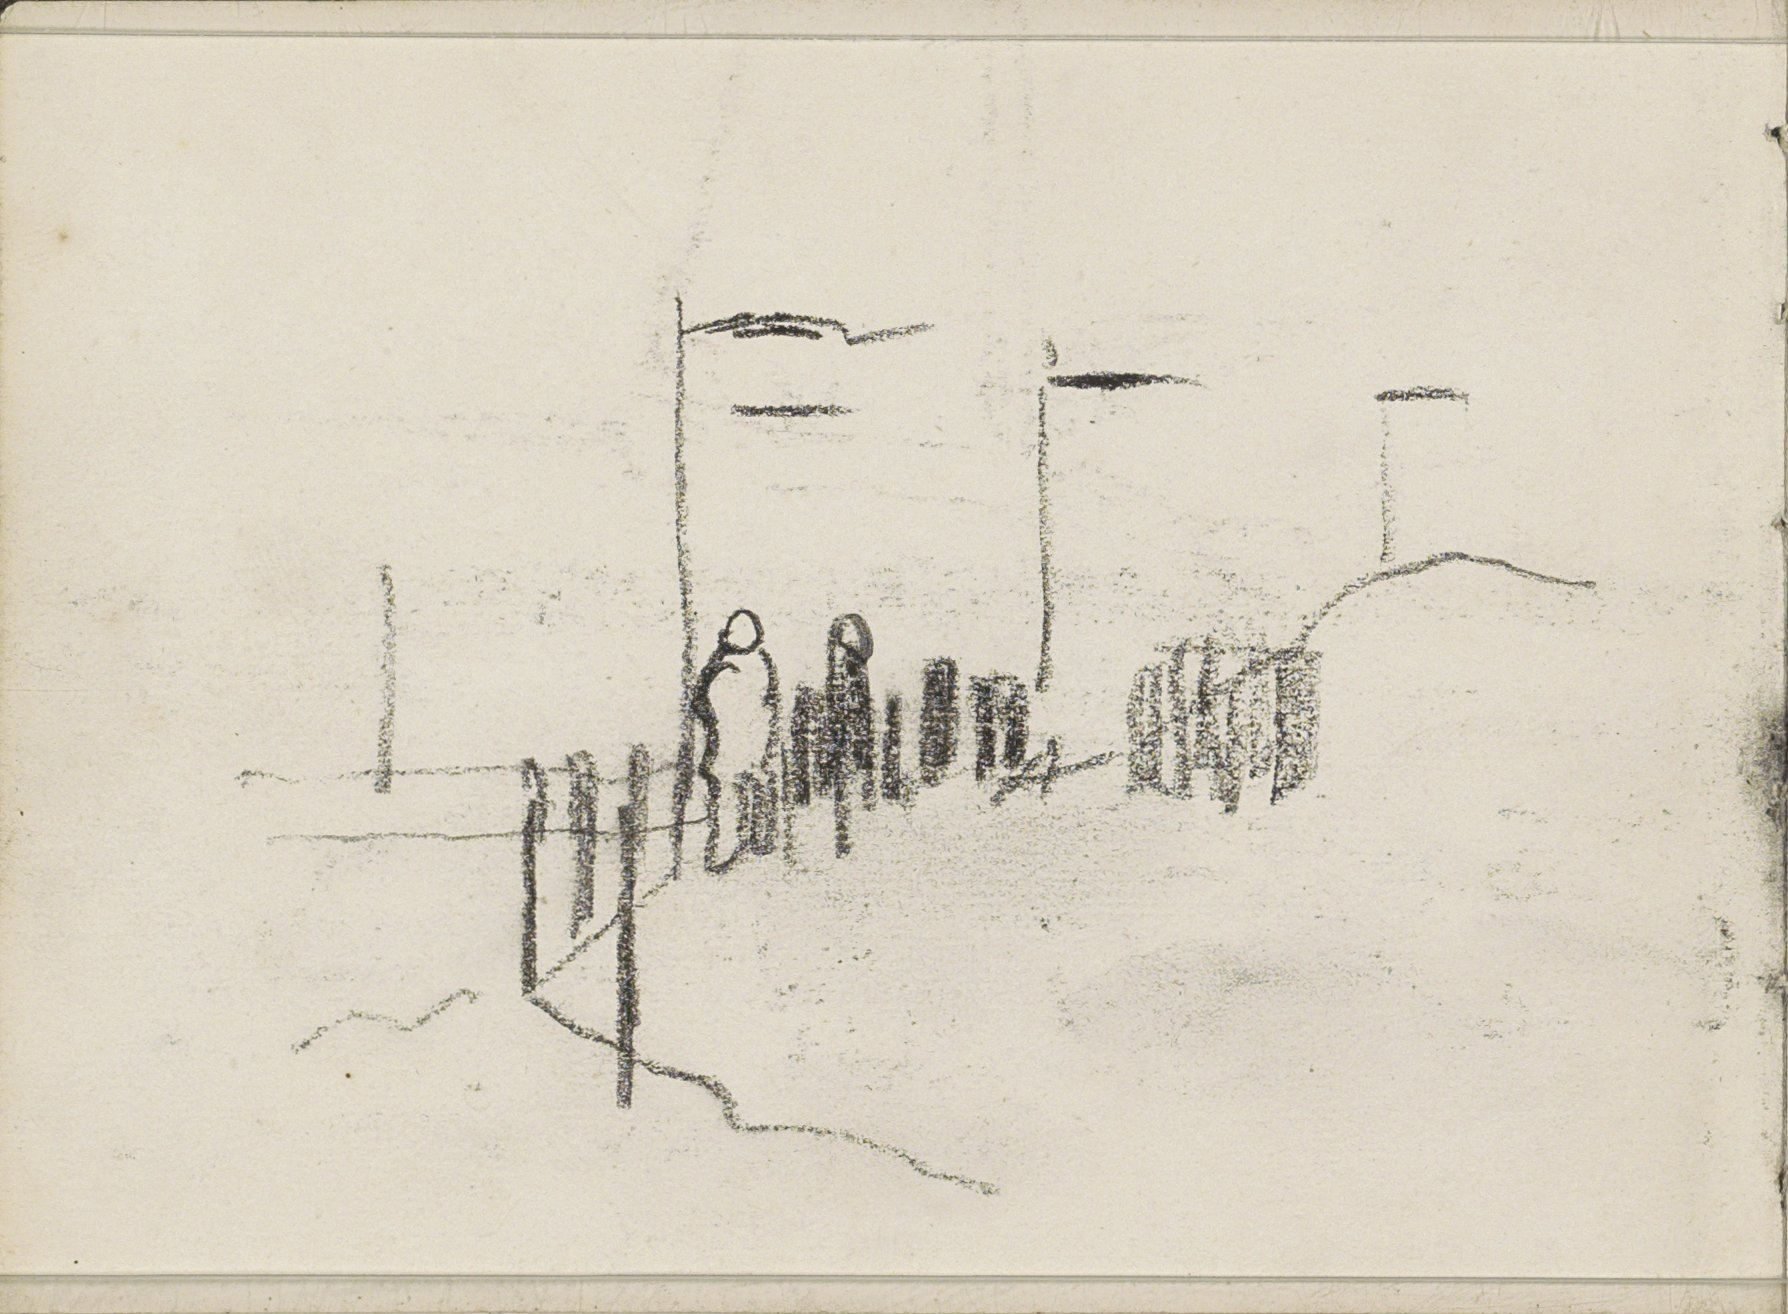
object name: sketchbook leaf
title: Figuren op een heuvel met drie vlaggenmasten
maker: anton mauve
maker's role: draughtsman, painter, print maker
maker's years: 1838-1888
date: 1848-1888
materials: chalk, paper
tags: flagpole, landscapes (+ landscape with figures, staffage)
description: Blad 1 verso uit een schetsboek met 33 bladen.